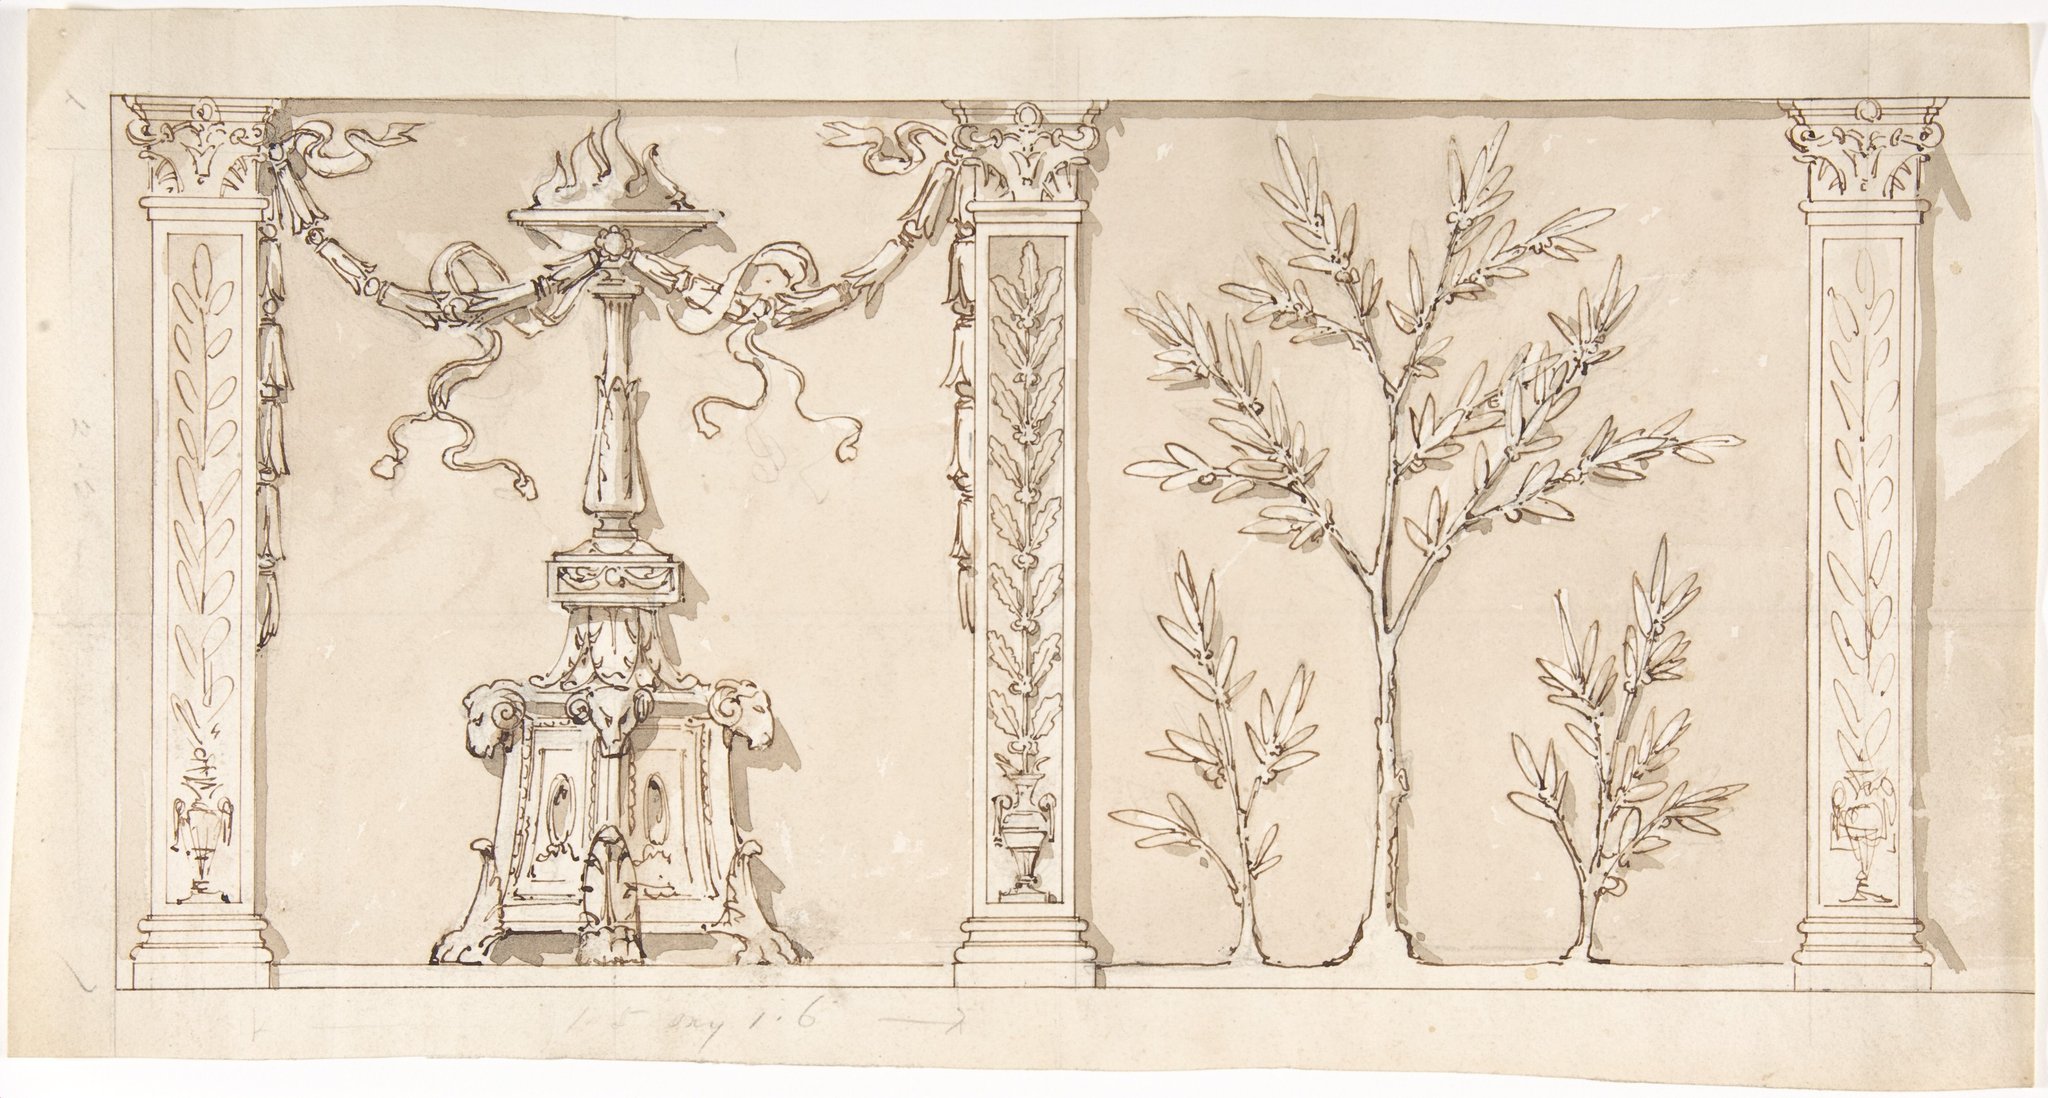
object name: drawing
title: Design for a Frieze or Wall Decoration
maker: anonymous, british, 19th century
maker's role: artist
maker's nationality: british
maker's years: 1800-1900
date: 1801-1900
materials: ink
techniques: pen